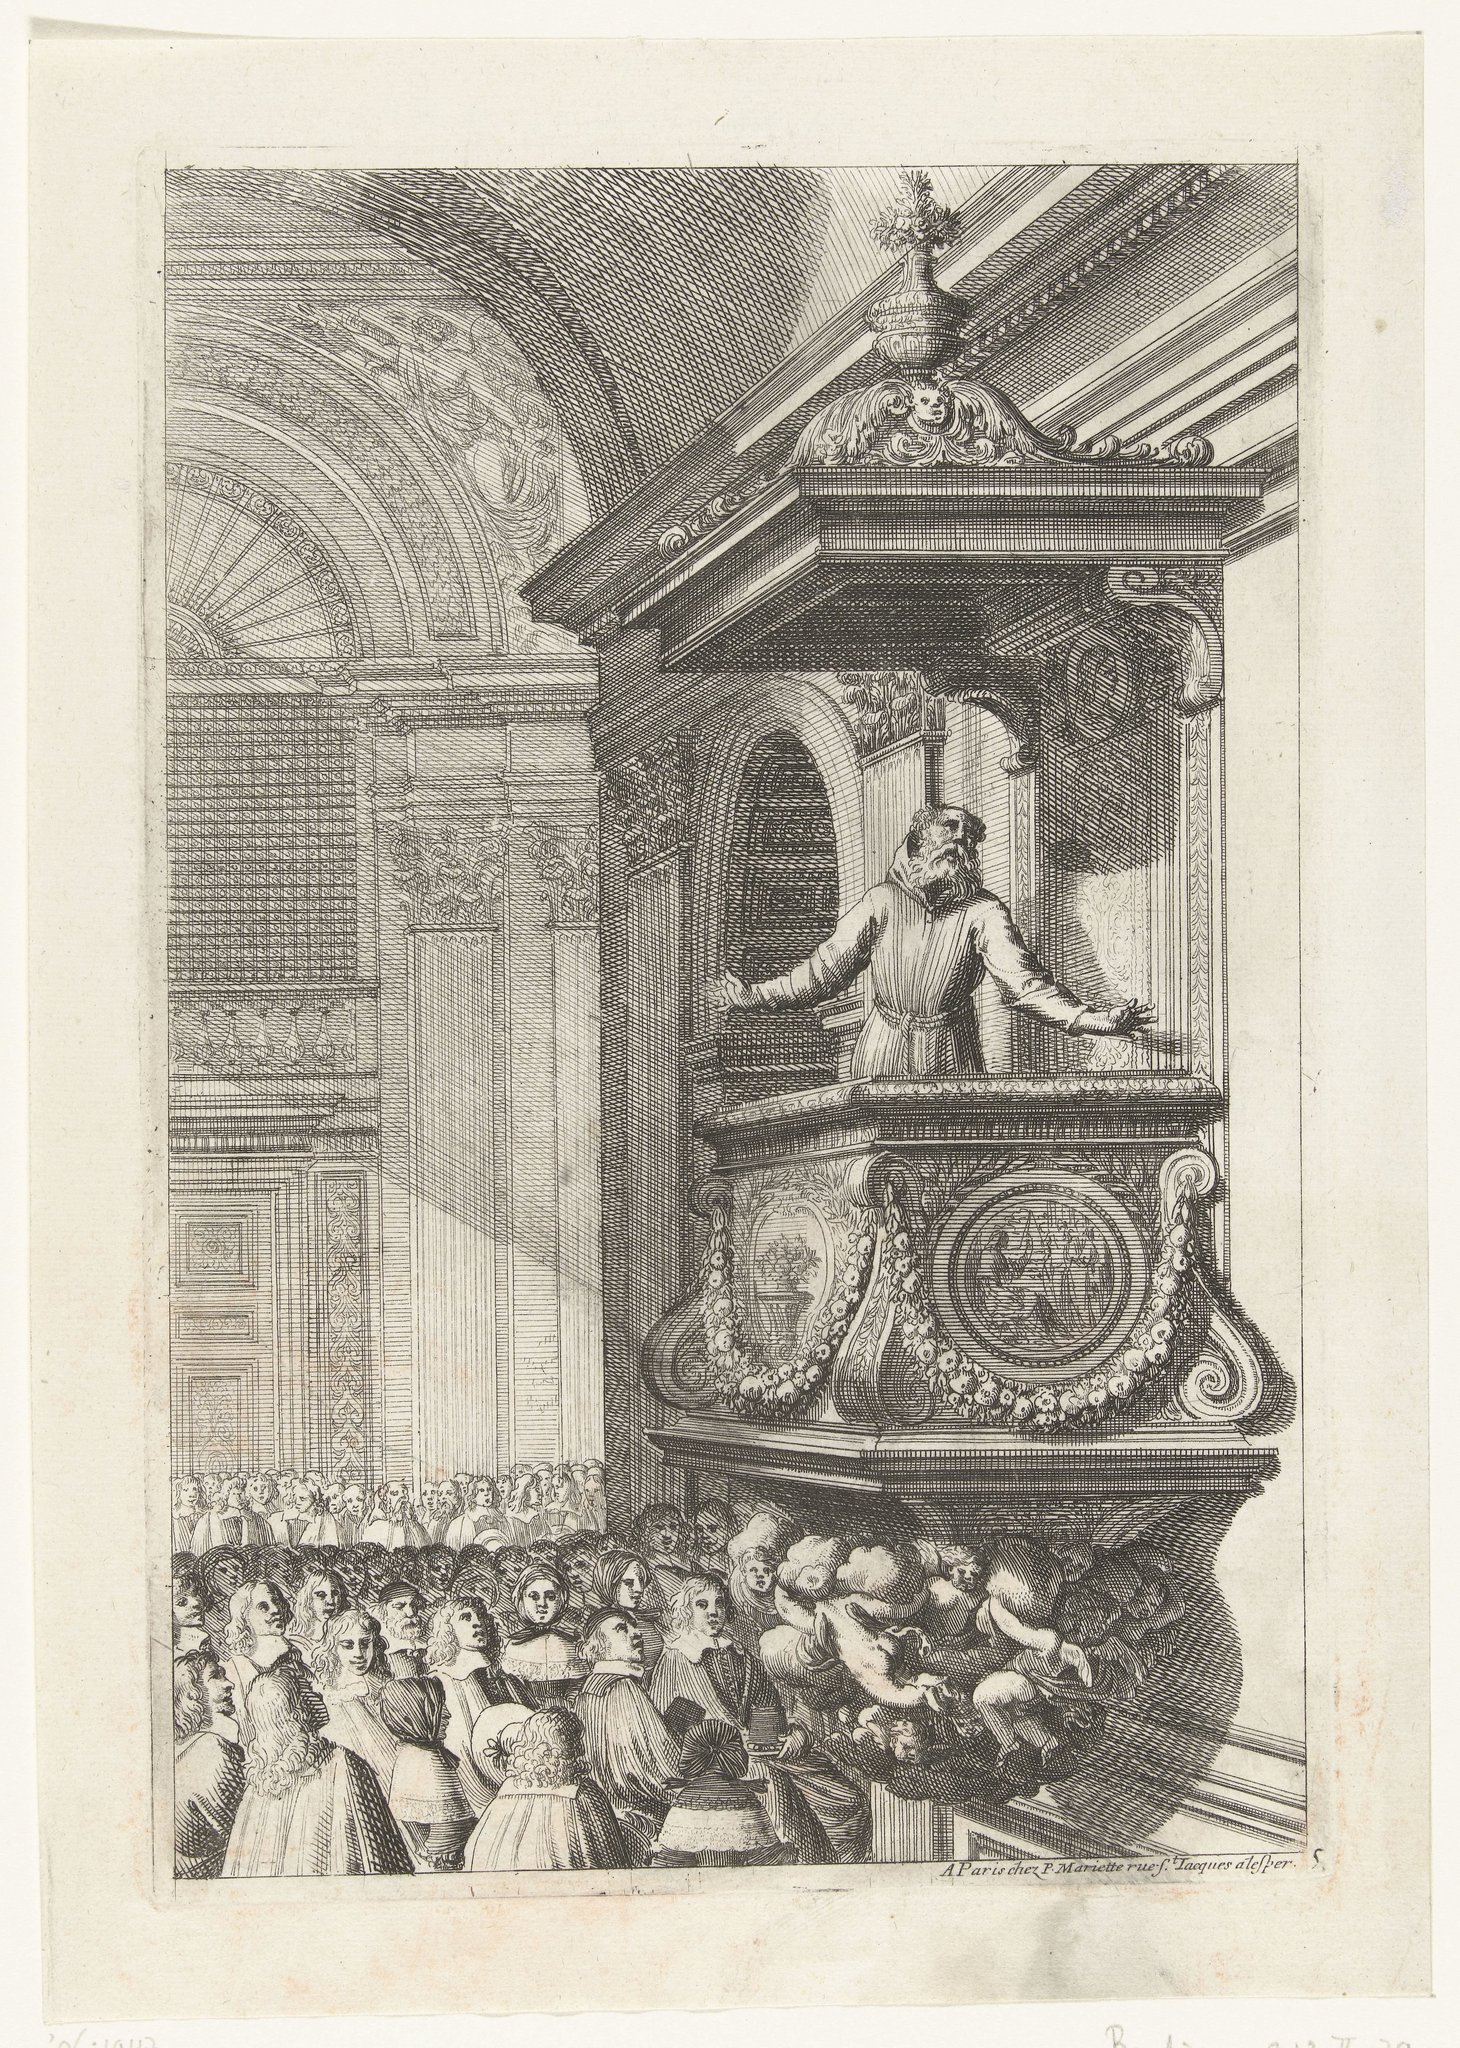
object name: print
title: Chaires de Predicateurs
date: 1659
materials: paper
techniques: etching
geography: france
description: Met hangend, vierkant lichaam gedecoreerd met consoles op de hoeken en medaillons en guirlandes van fruit ertussenin. Uit tweede editie.